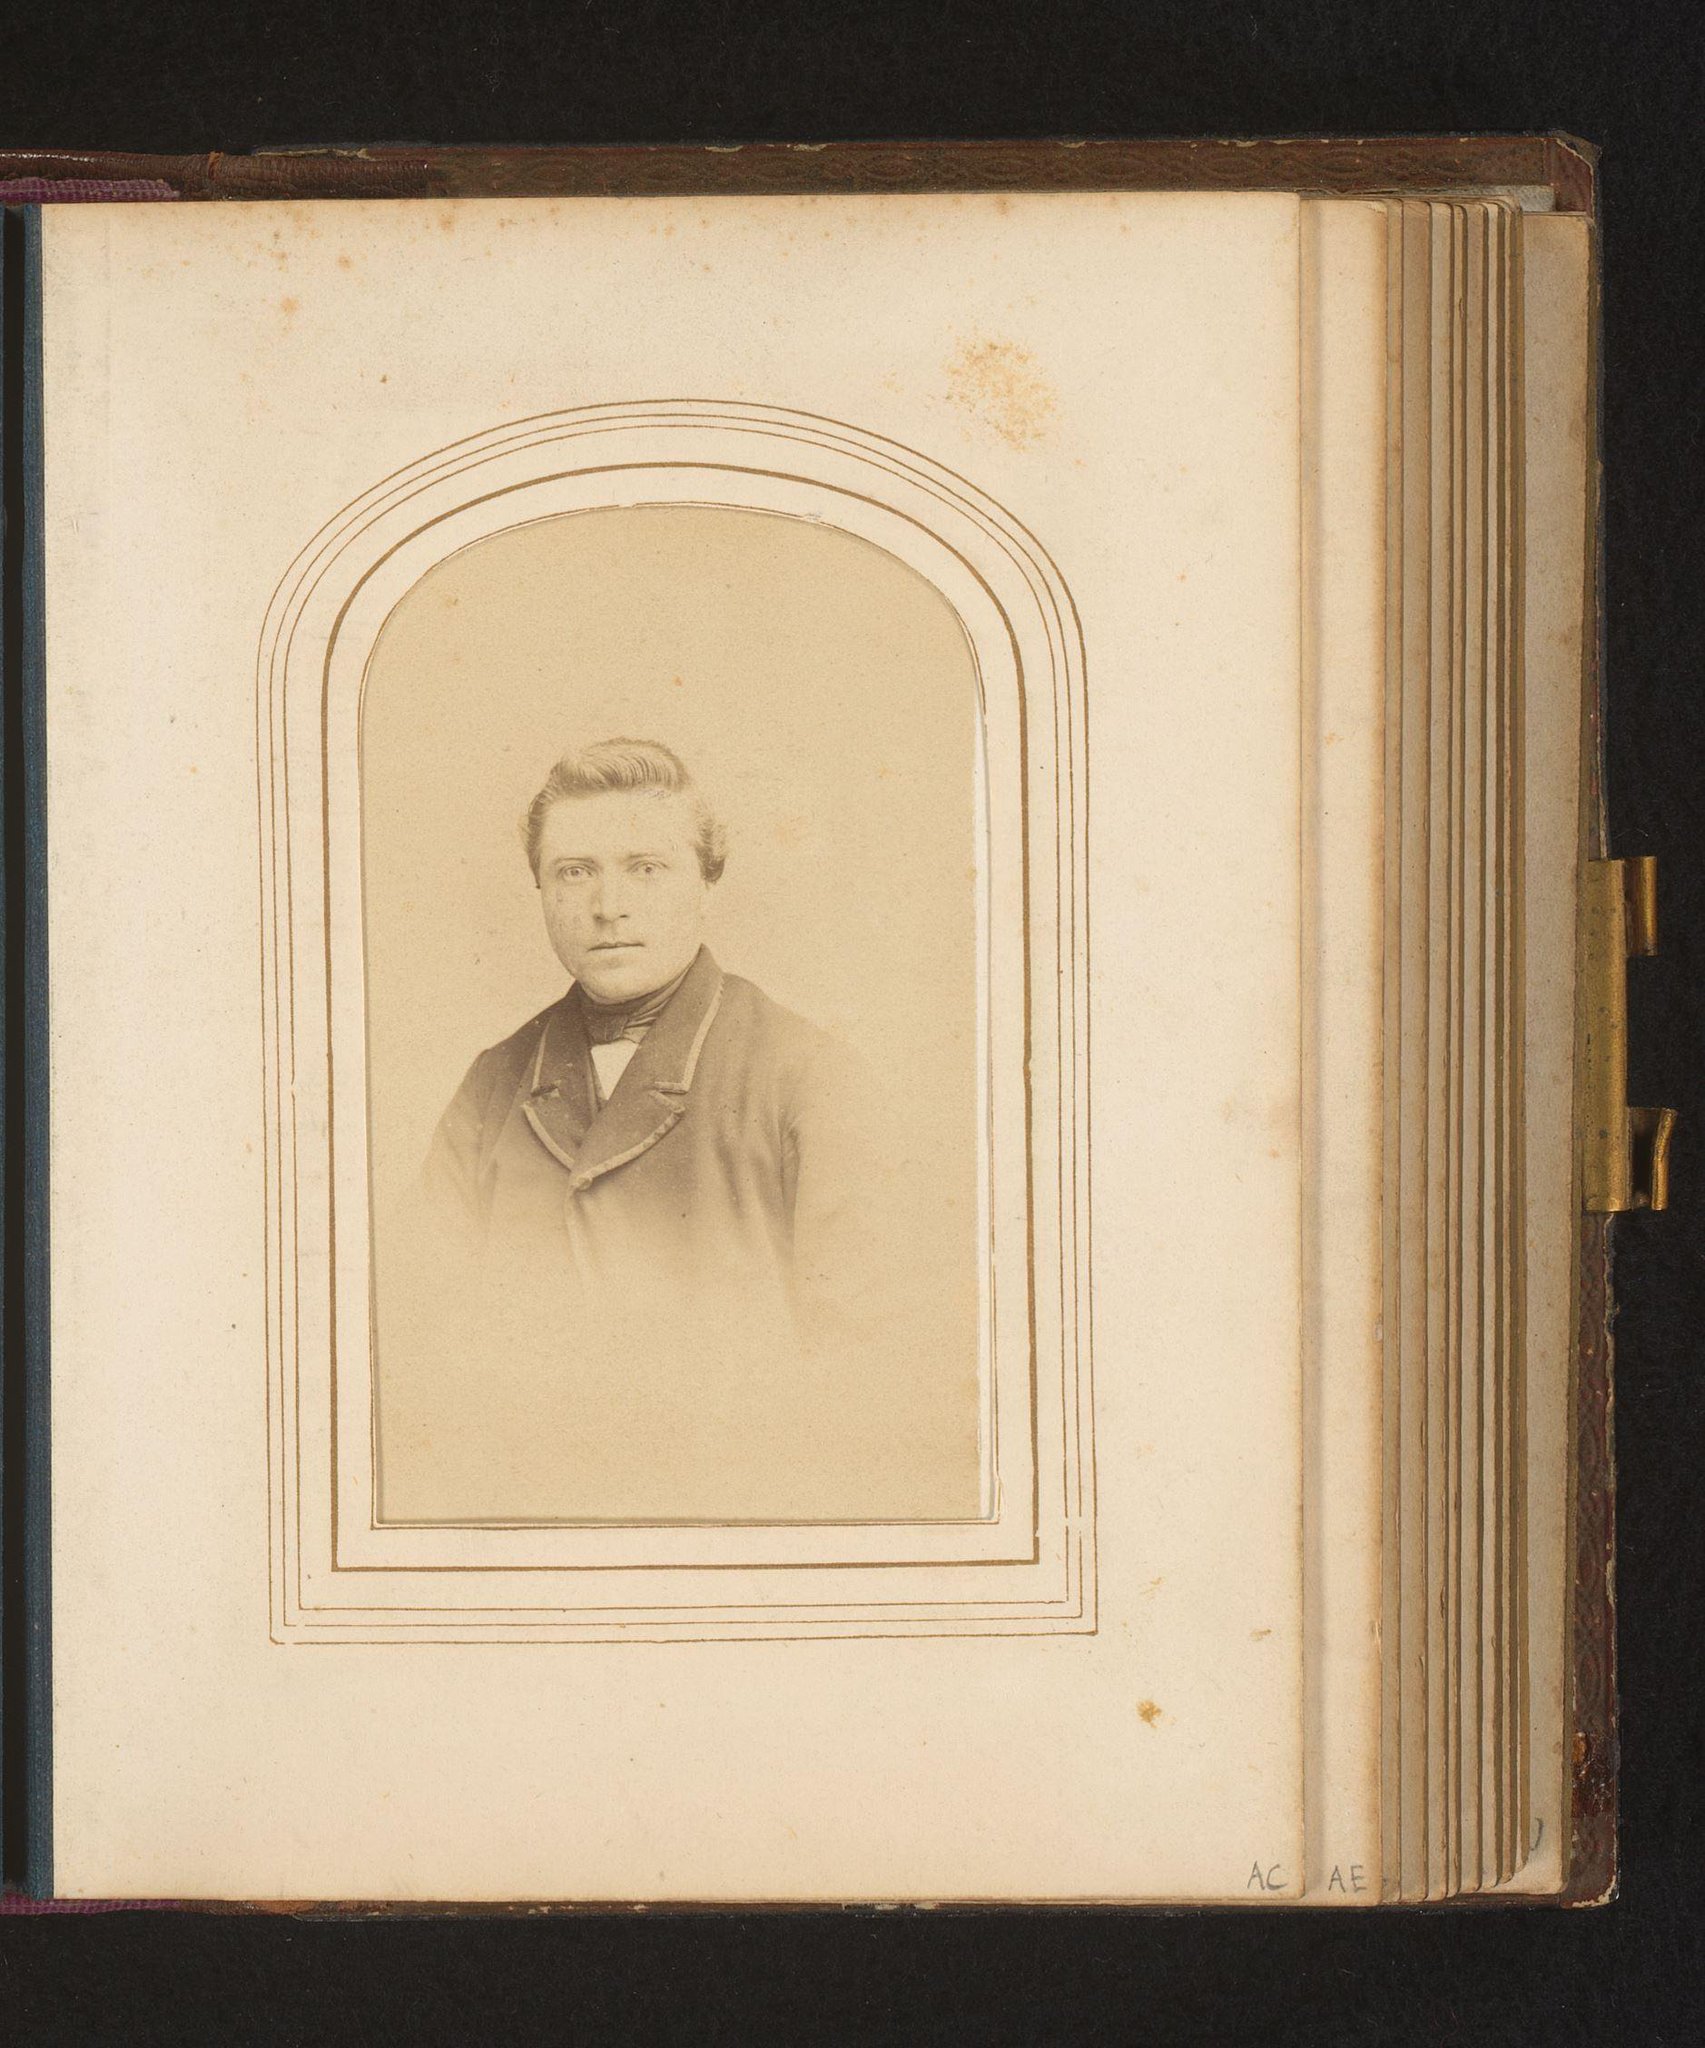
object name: album leaf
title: Portret van een man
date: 1866-1880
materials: cardboard, photographic support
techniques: albumen print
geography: groningen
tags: historical persons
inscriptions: inscription: ‘(...)/ ZILVEREN MEDAILLE AMSTERDAM 1866/ VON KOLKOW & Co/ GRONINGEN.’